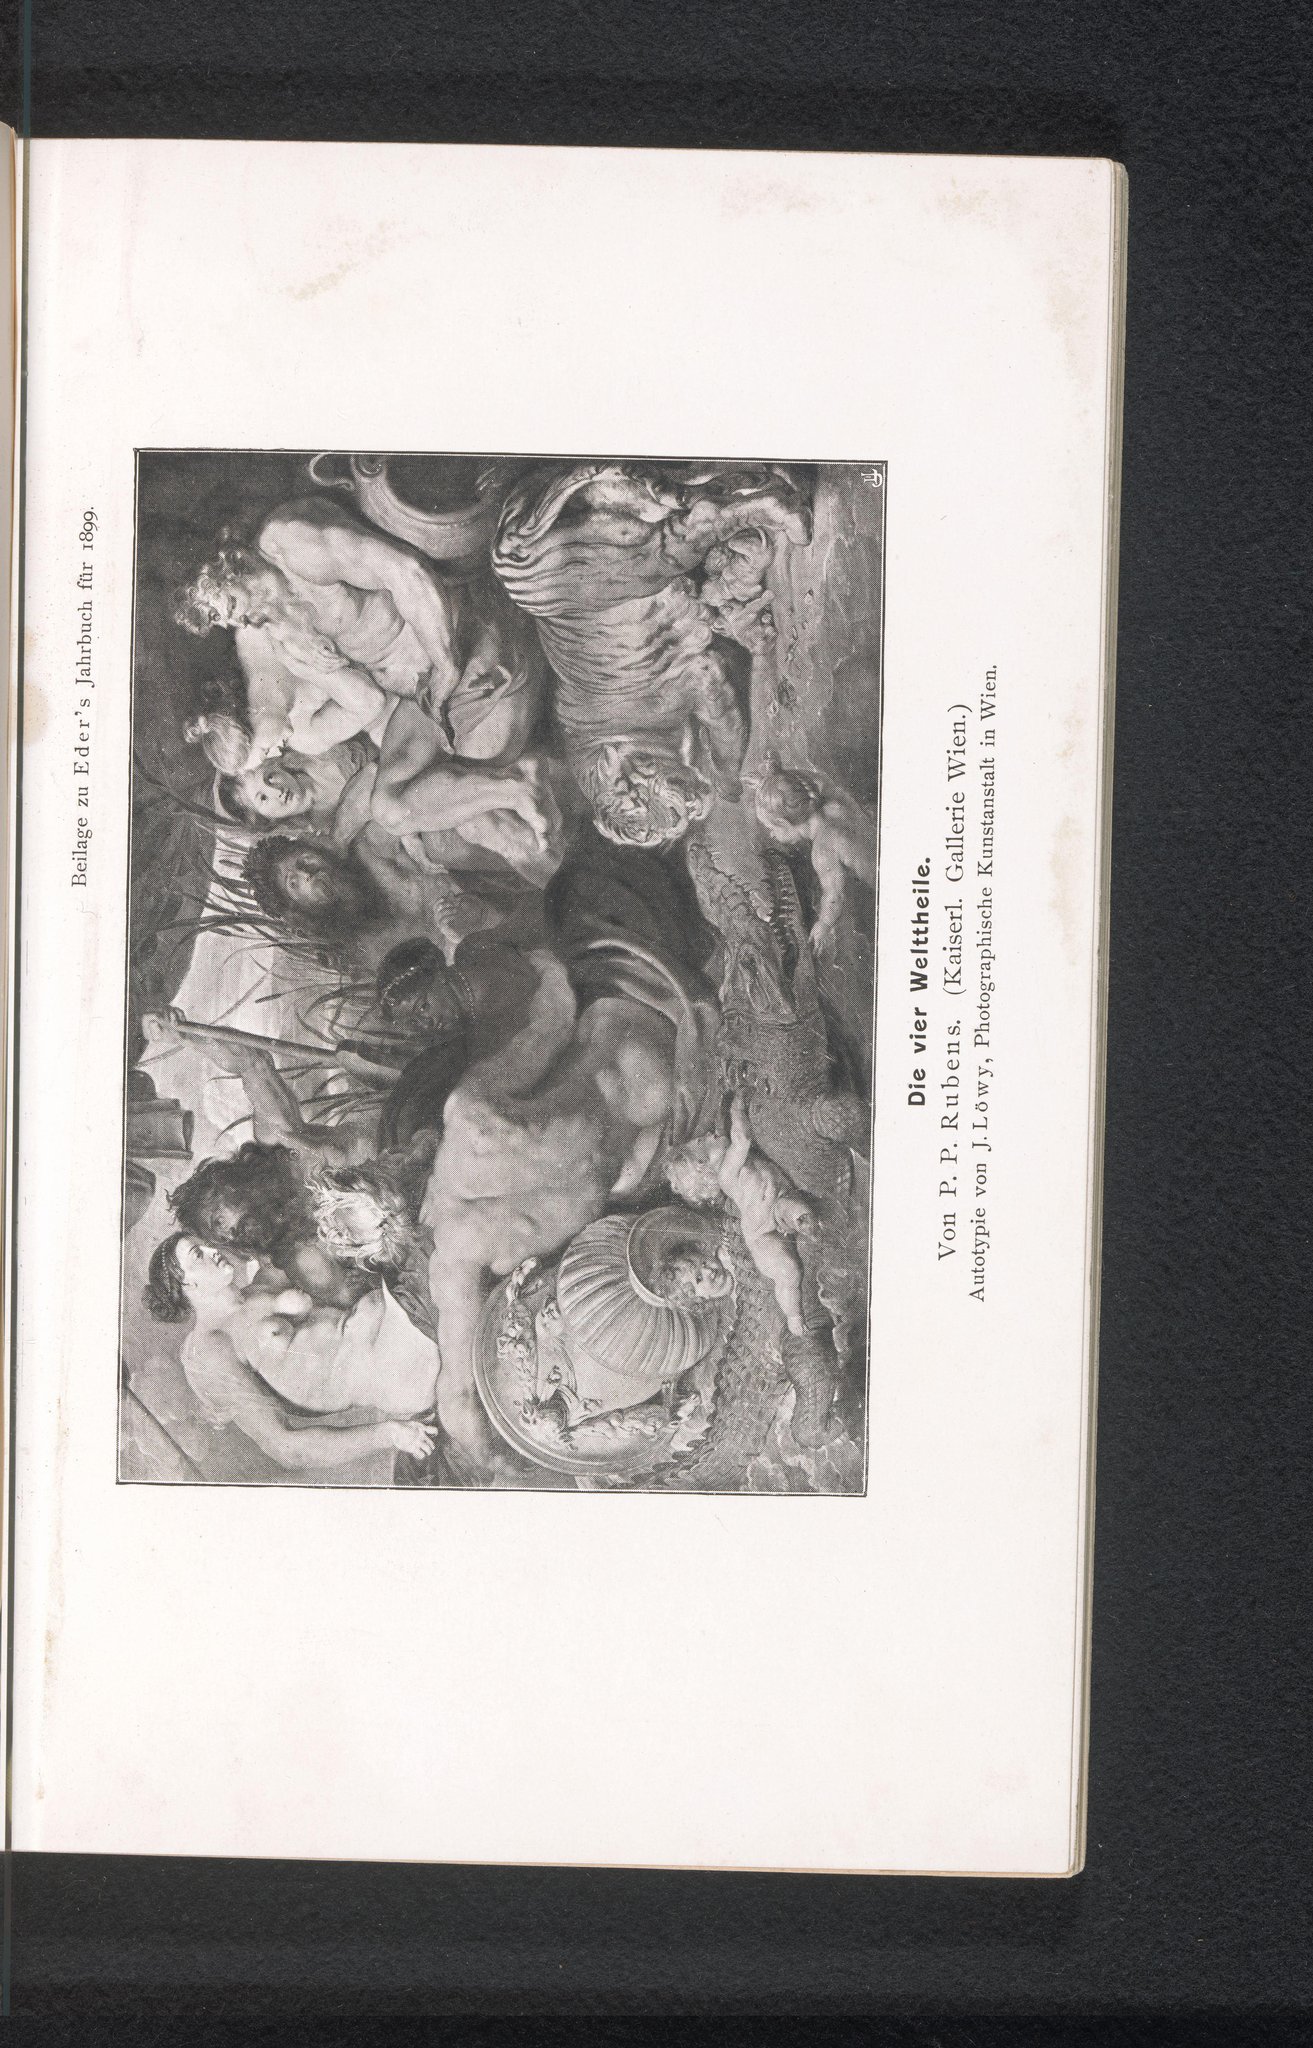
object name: reproduction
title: Reproductie van De vier continenten door Peter Paul Rubens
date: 1894-1899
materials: paper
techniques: autotype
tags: continents represented allegorically, painting, drawing and the graphic arts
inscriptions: inscription: ‘Beilage zu Eder's Jahrbuch für 1899.’, inscription: ‘Kaisel. Gallerie Wien’